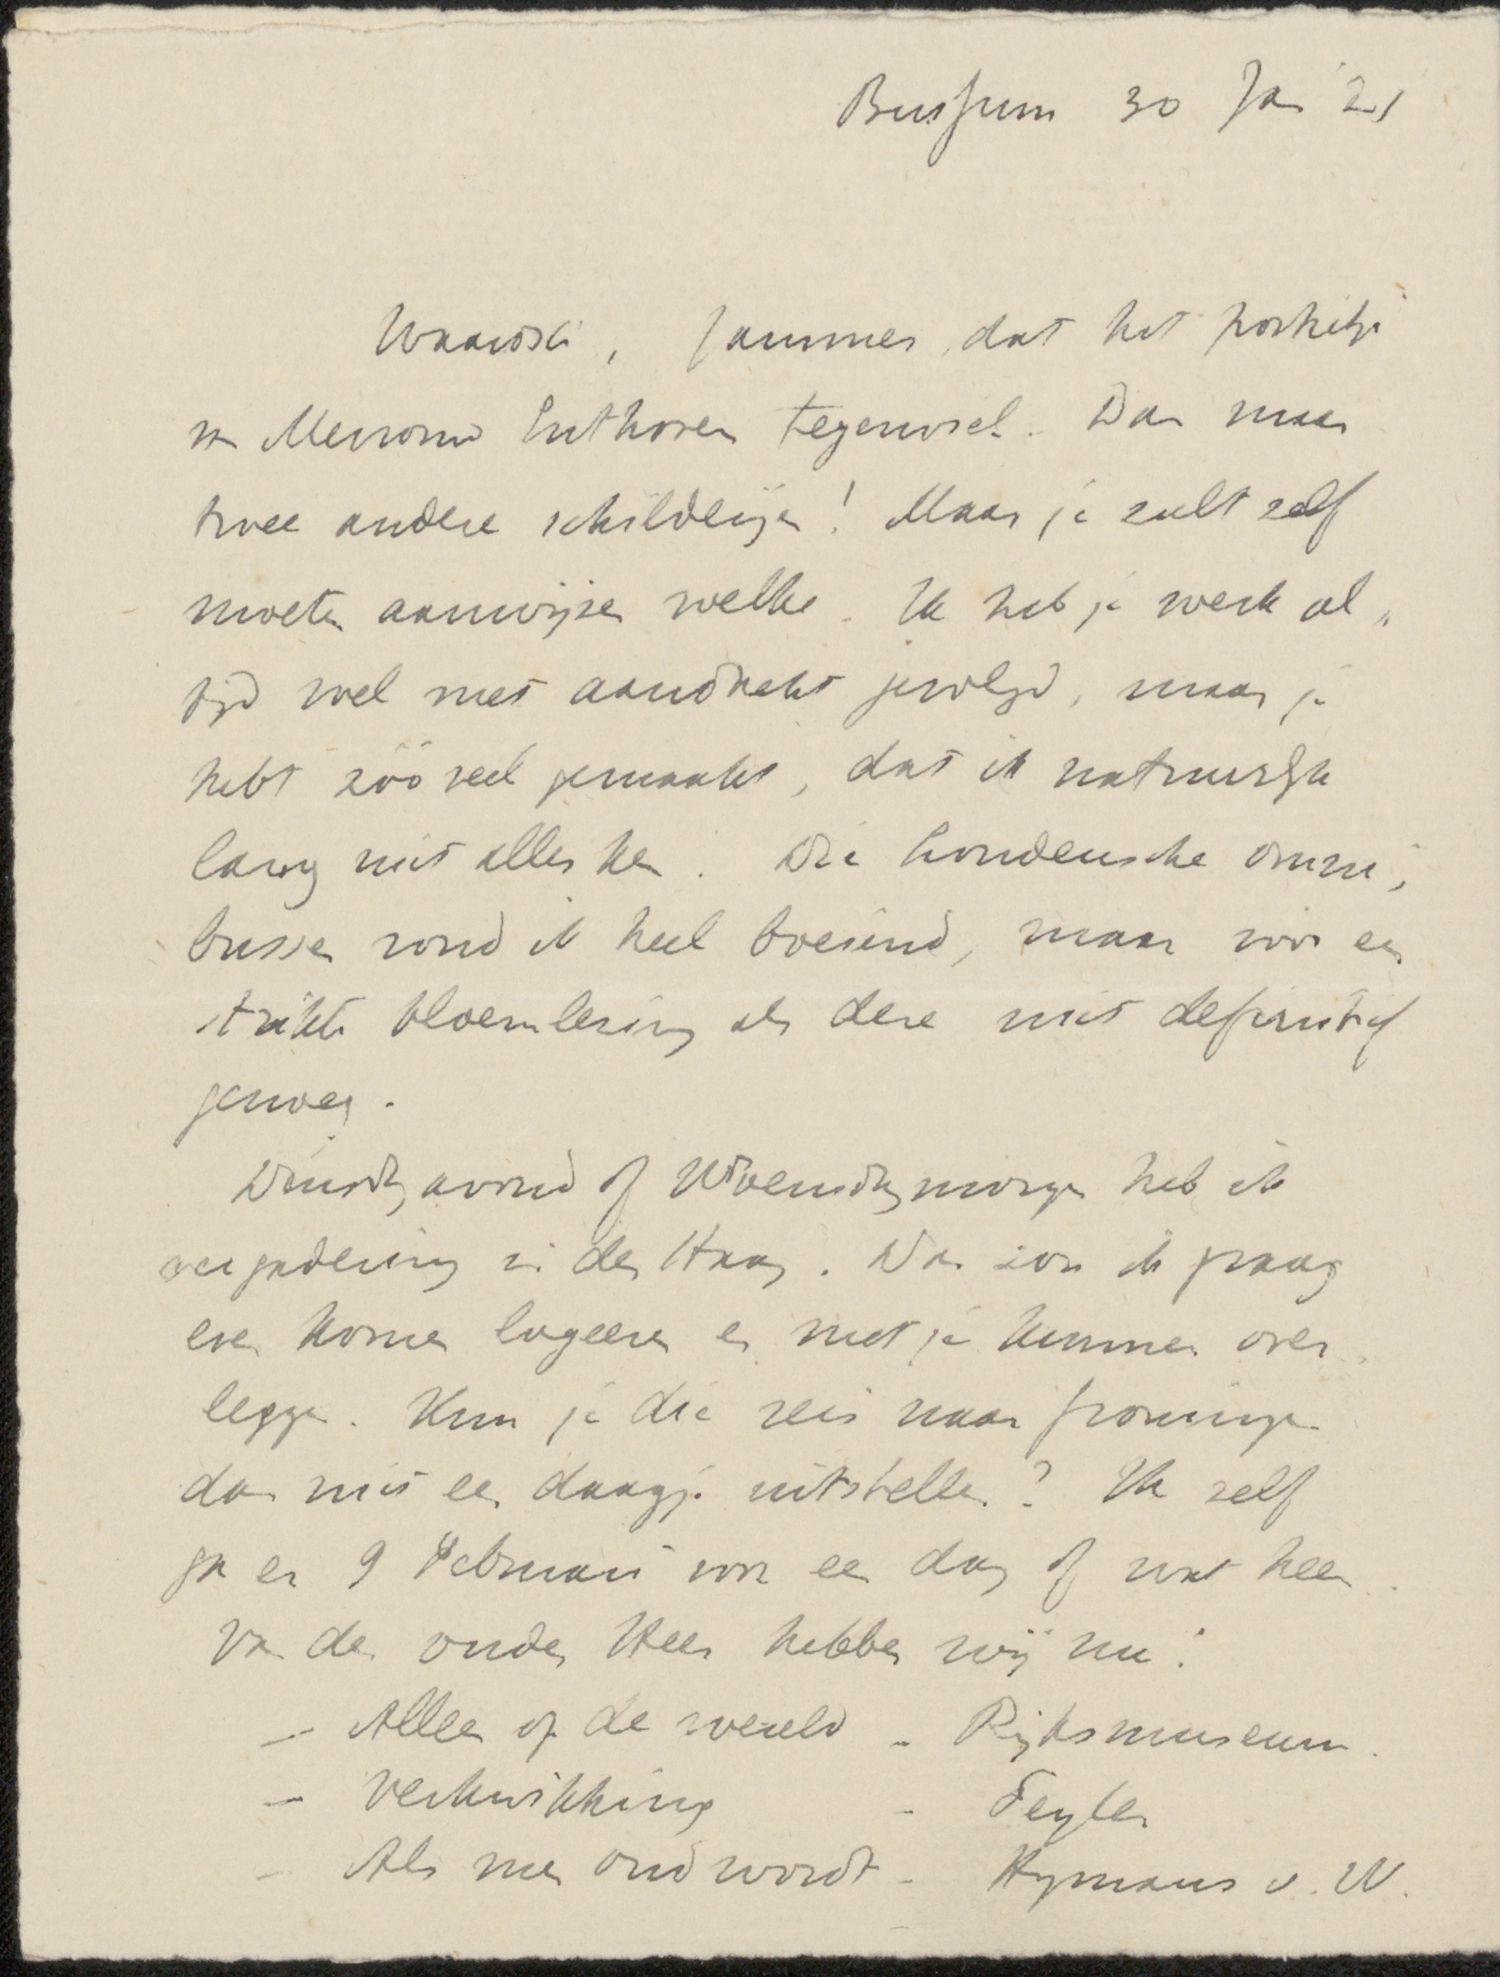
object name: letter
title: Brief aan Isaac Israels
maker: jan veth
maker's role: designer, draughtsman, painter, print maker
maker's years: 1864-1925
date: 1921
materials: ink, paper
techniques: pen, writing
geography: bussum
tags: rotterdam, jozef israëls, the hague, isaac israels, exhibition ~ art, historical persons (portraits and scenes from the life), paris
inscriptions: collector's mark: ‘RPK’, watermark